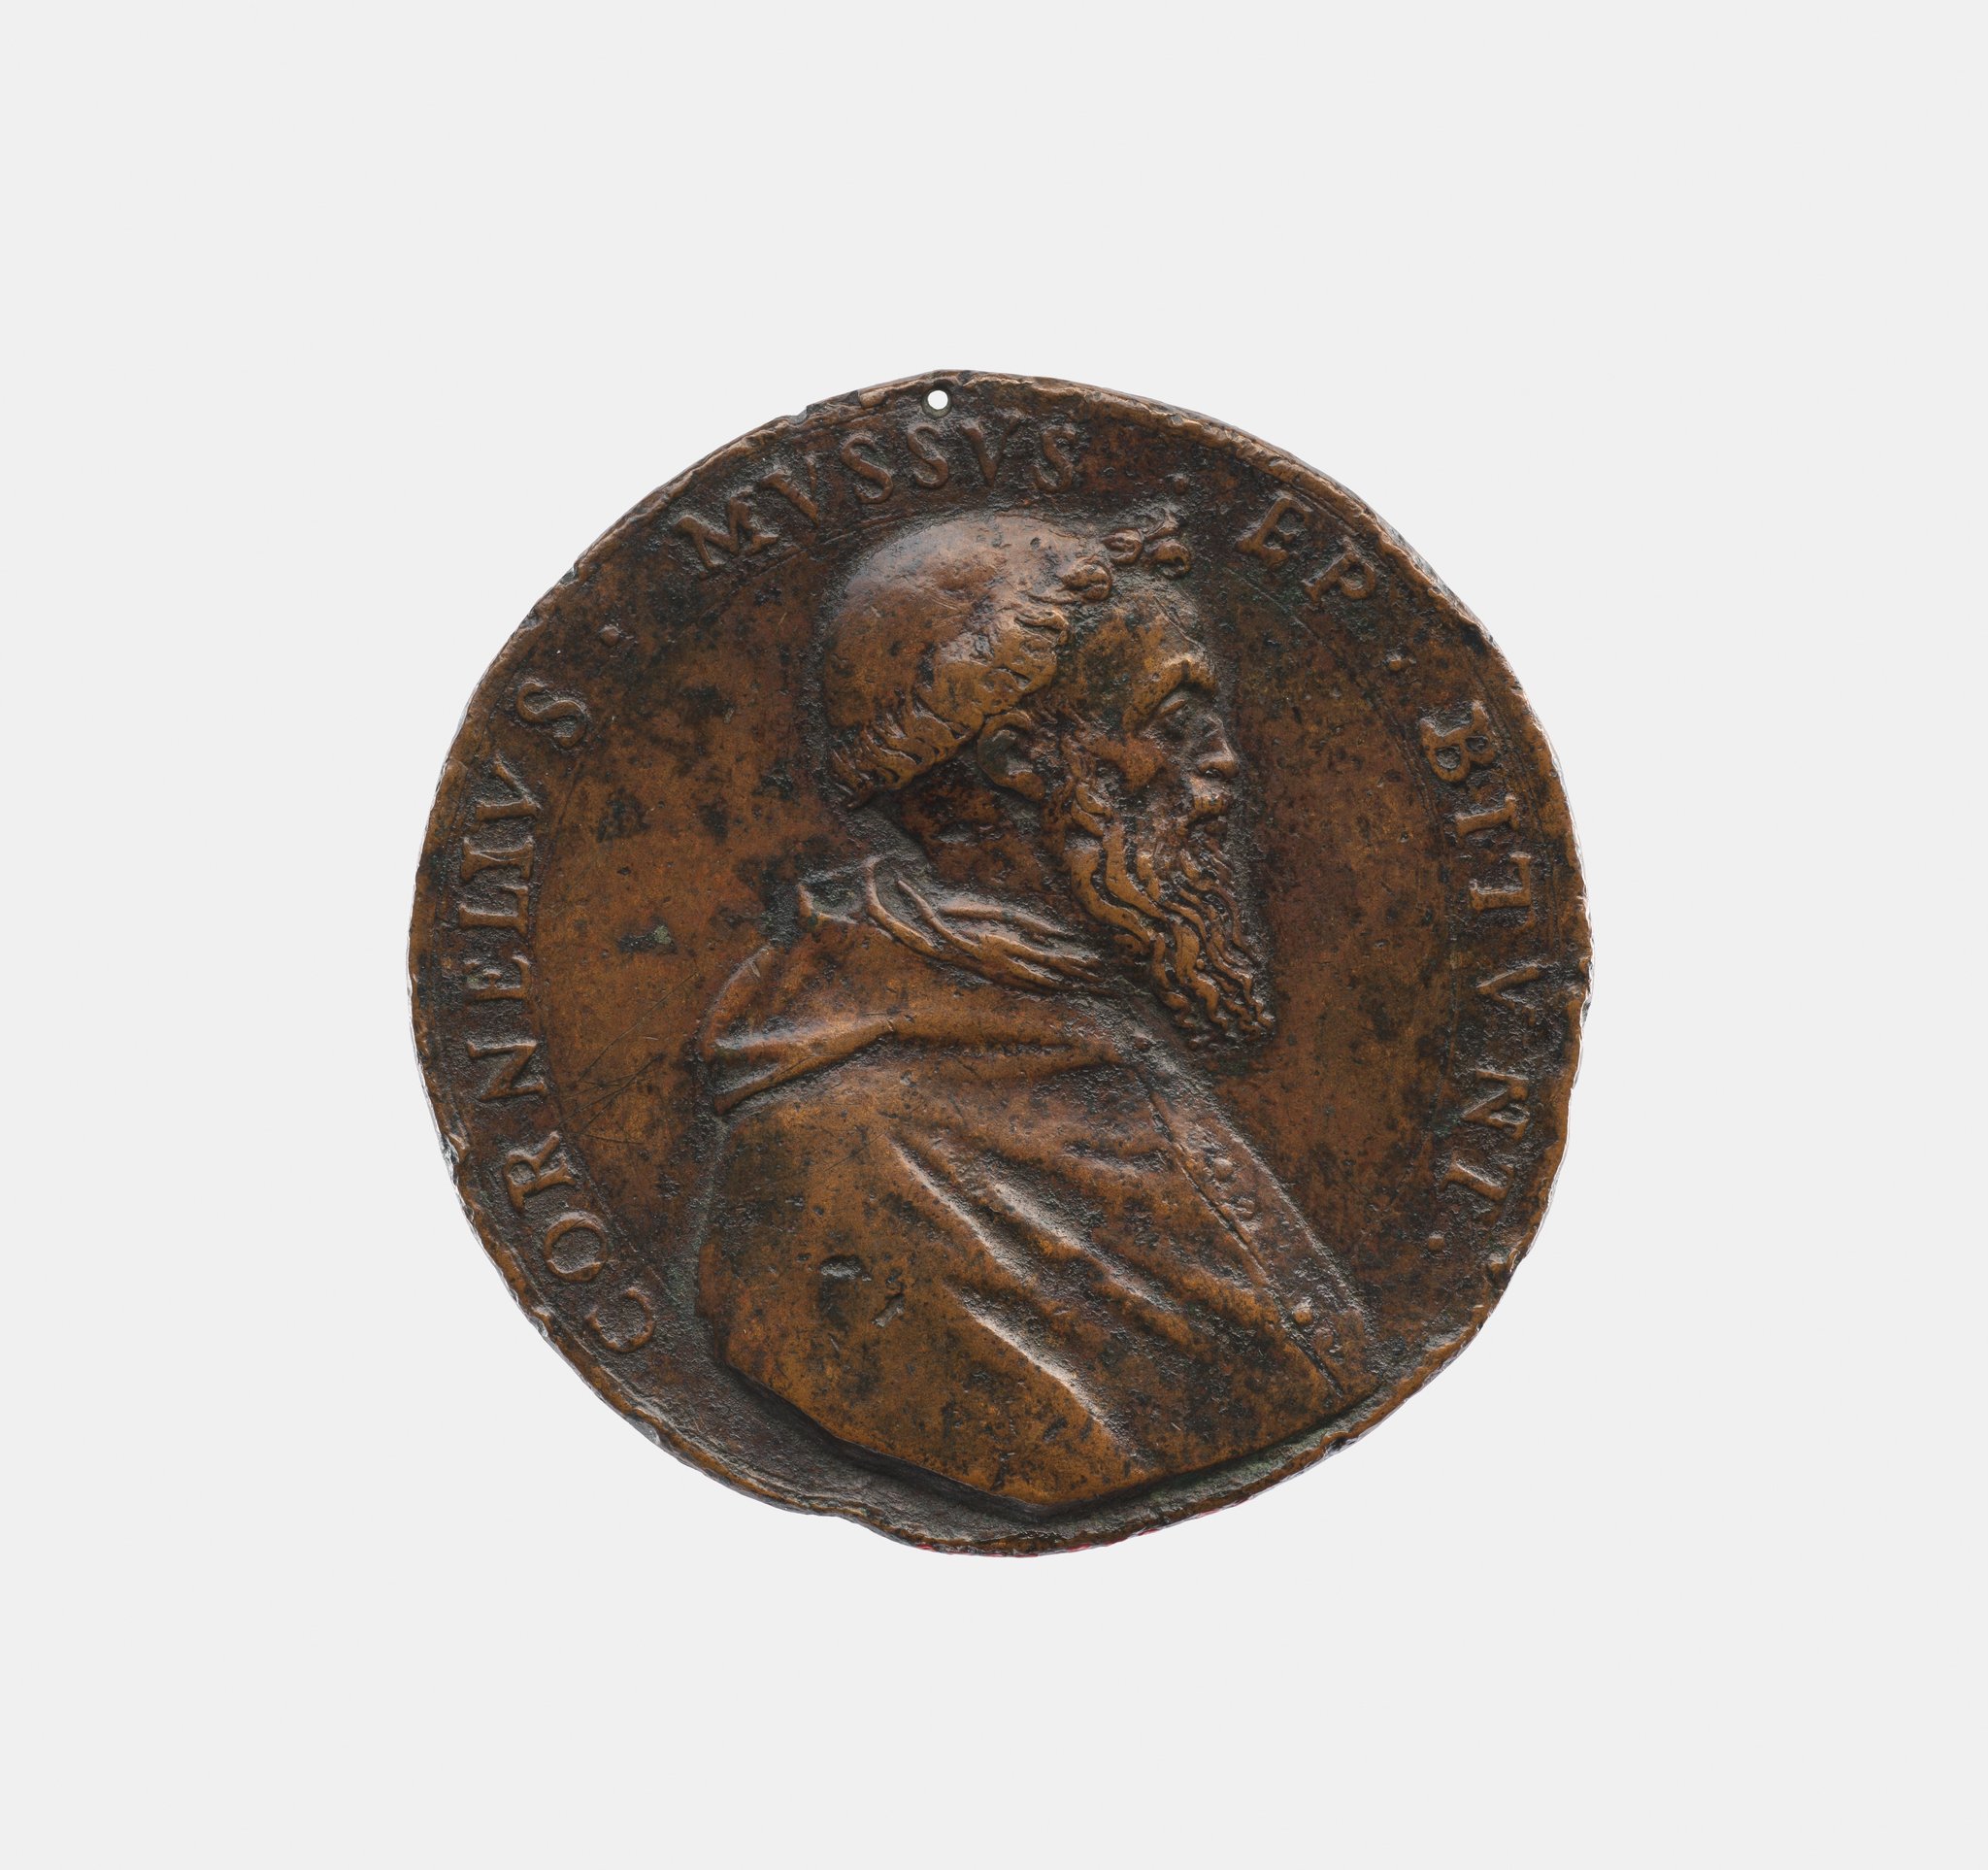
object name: medal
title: Cornelio Musso, Franciscan, Bishop of Bitonto 1544, d. 1574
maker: Anonymous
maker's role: artist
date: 1500-1599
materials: bronze